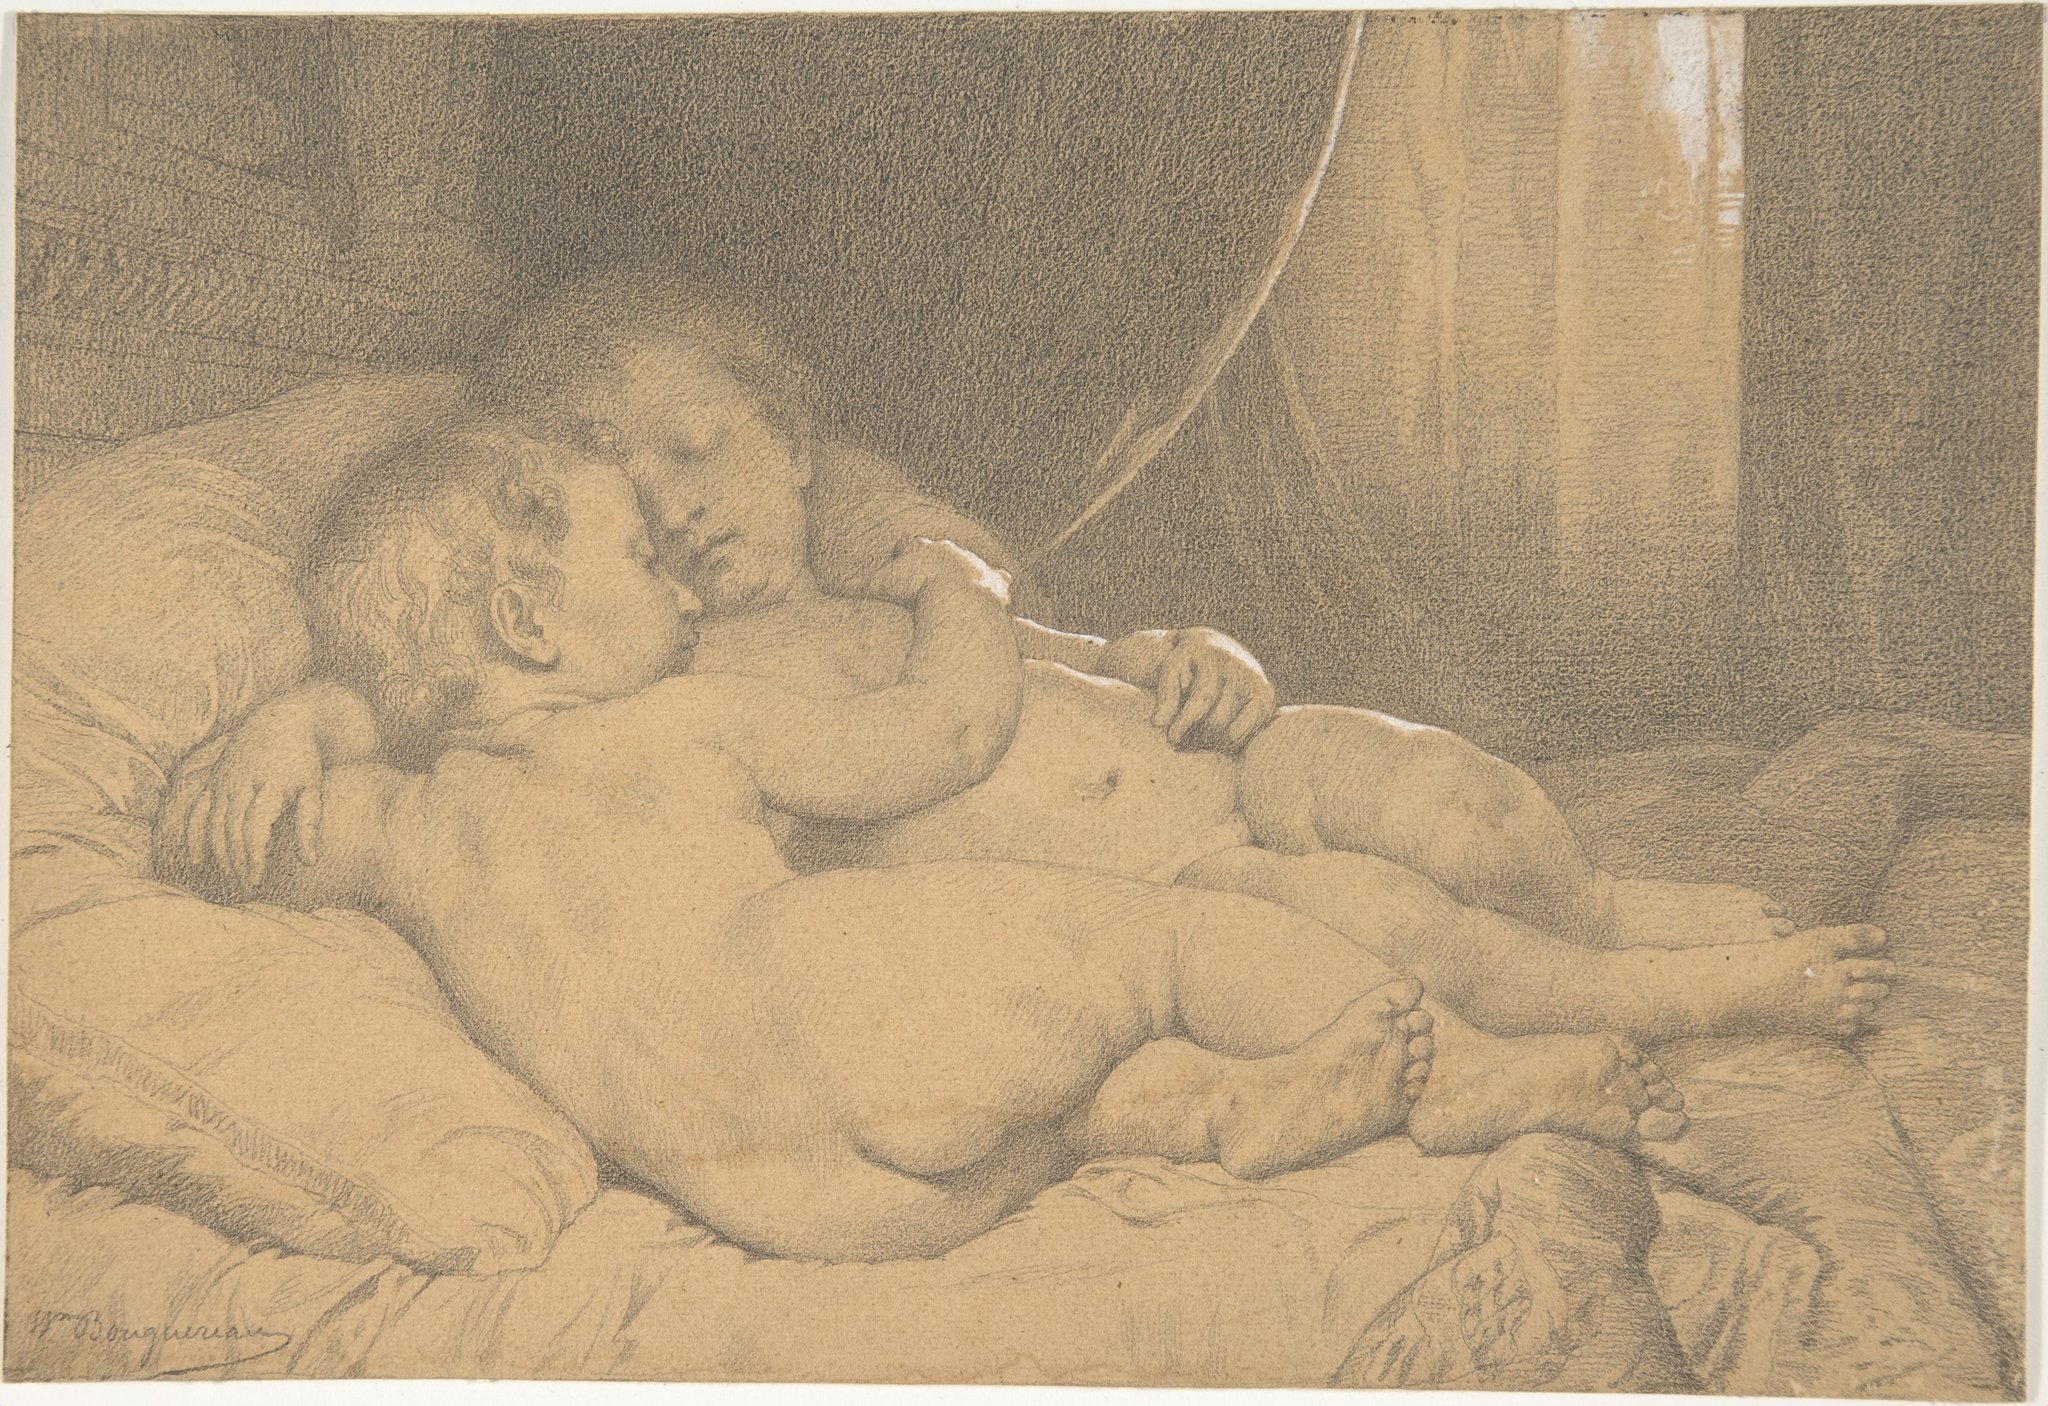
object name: drawing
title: Two Sleeping Children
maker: william bouguereau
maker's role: artist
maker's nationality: french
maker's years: 1825-1905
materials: chalk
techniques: heightening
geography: france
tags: sleeping,children